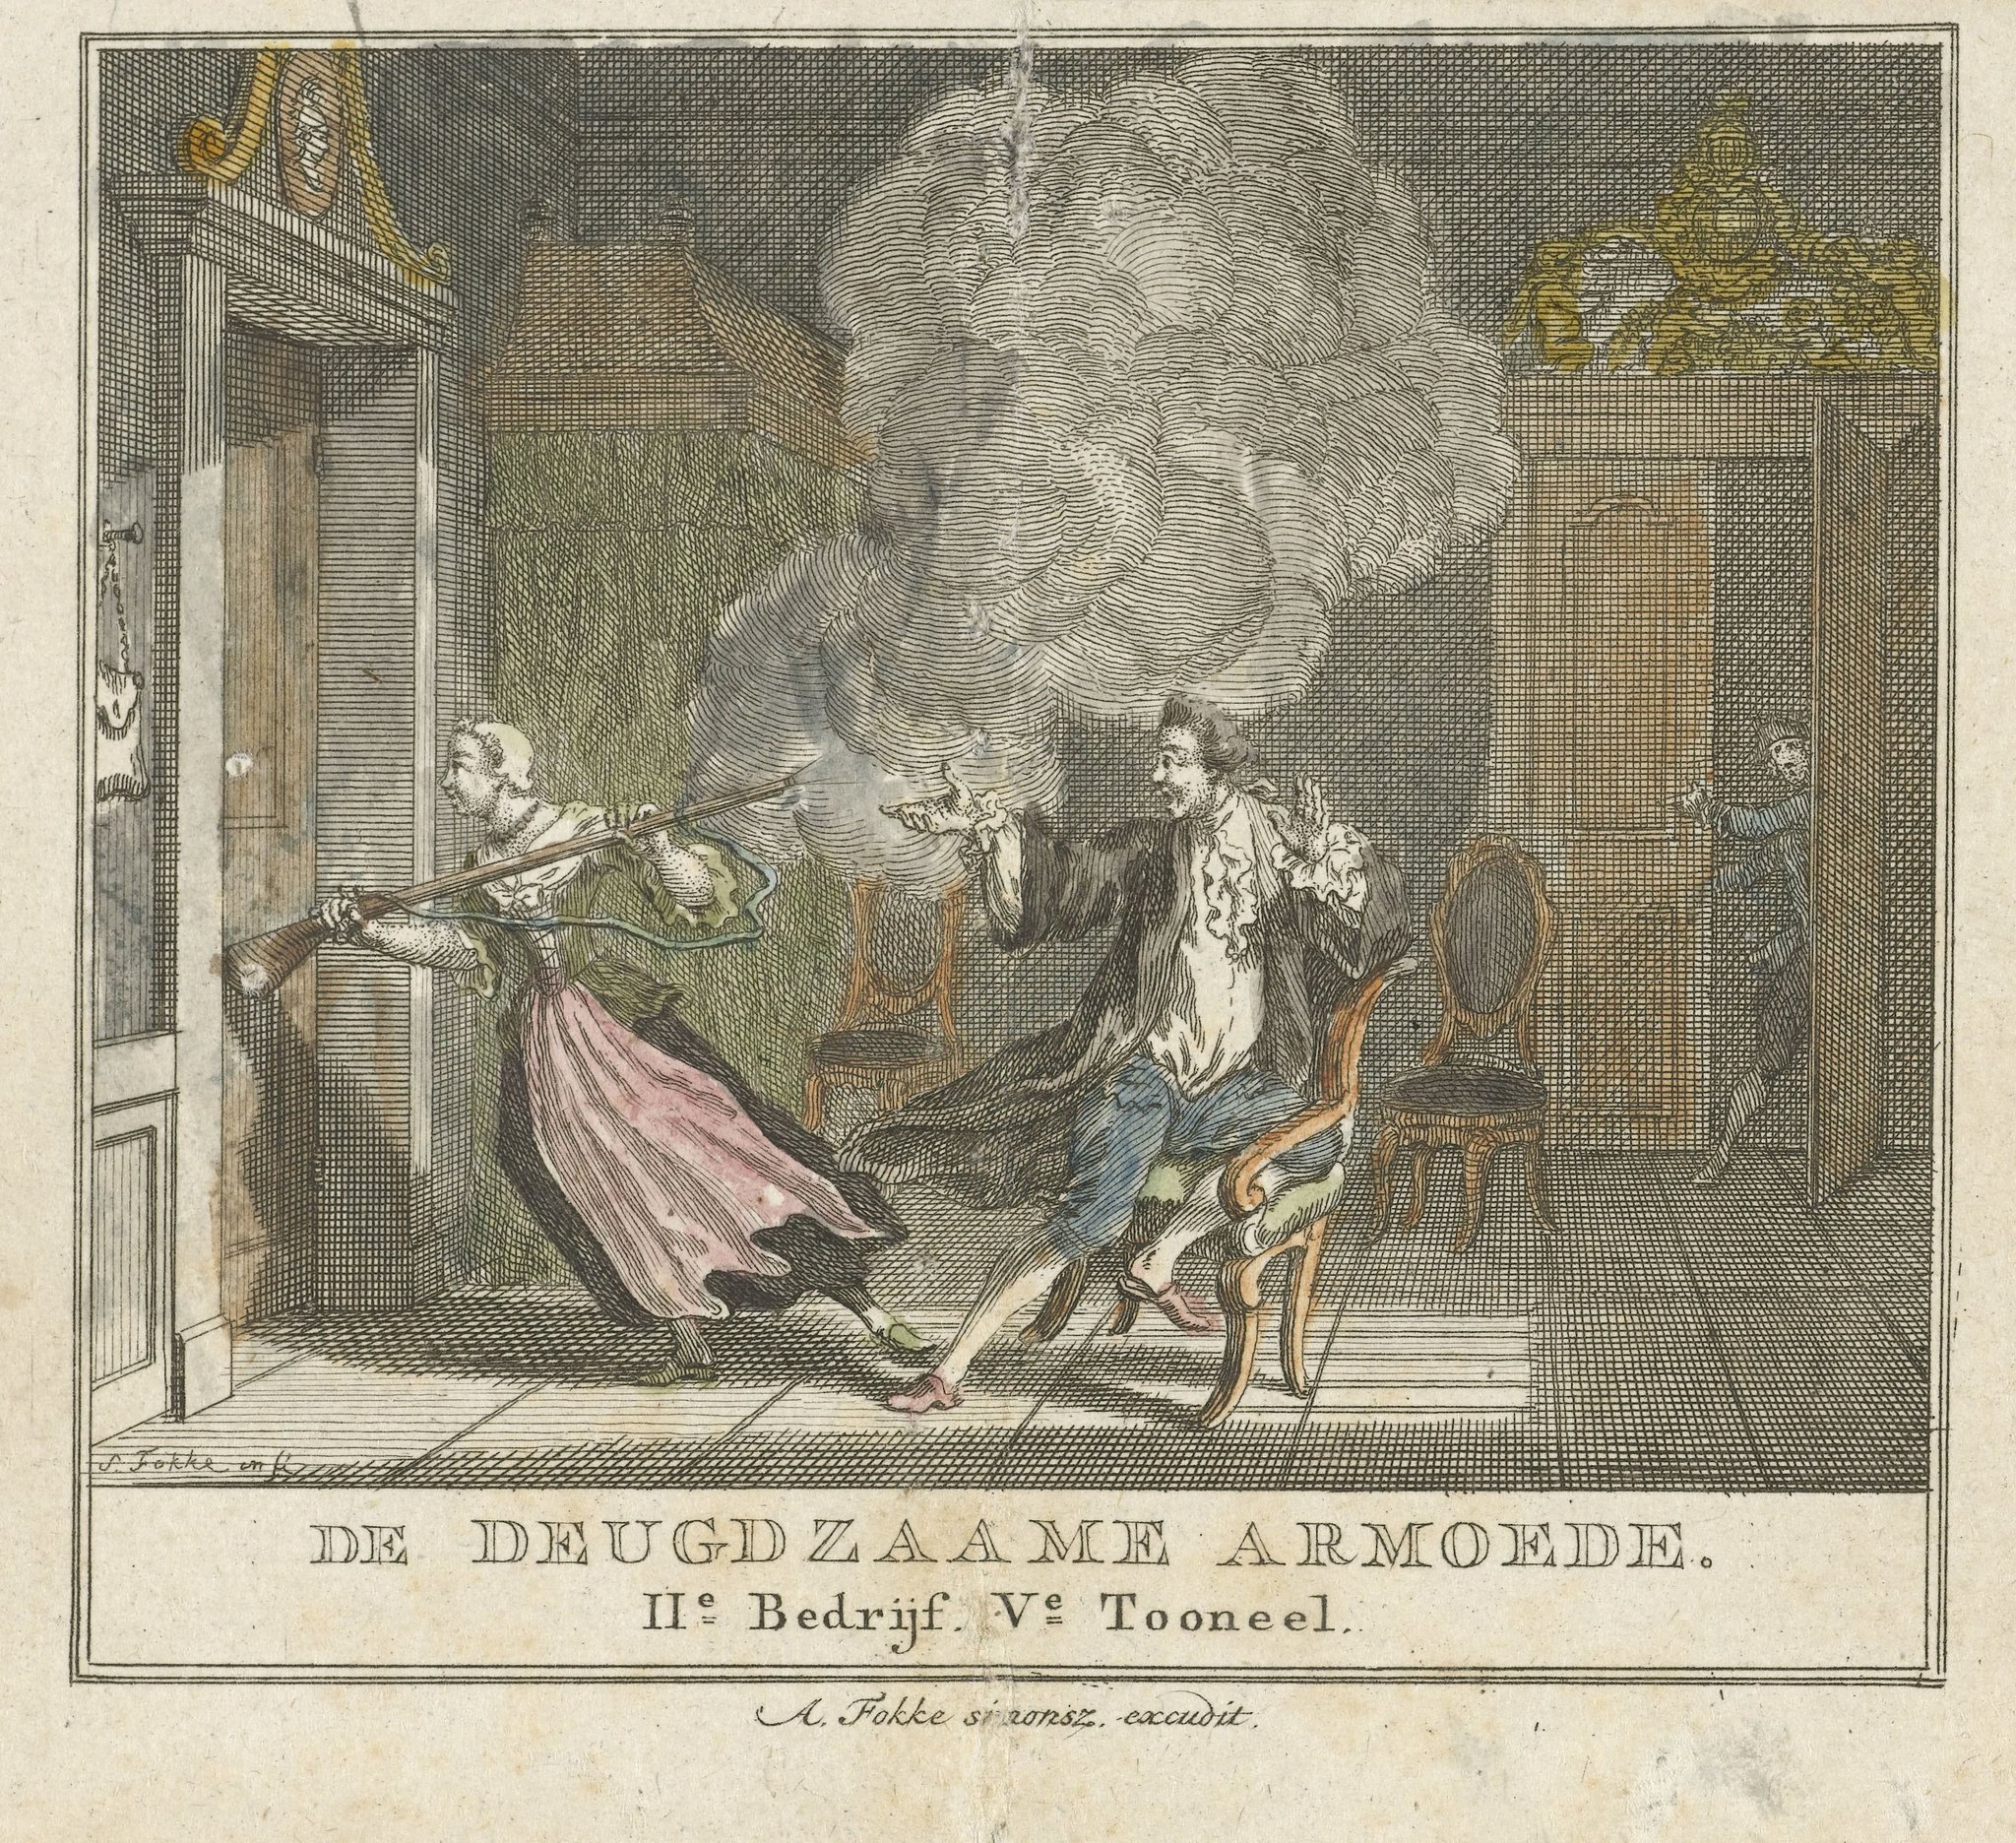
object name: print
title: De Deugdzaame Armoede. IIe Bedrijf. Ve Tooneel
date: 1774-1793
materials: paper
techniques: etching, hand coloring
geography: amsterdam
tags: firearms: rifle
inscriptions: collector's mark: Lugt 2228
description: In een vertrek probeert een vrouw de deur met de kolf van een geweer open te krijgen. Op een stoel achter haar zit een man die verschrikt wijst op de loop van het geweer waaruit rook komt. Deze prent is vervaardigd voor het blijspel "De deugdzaame armoede" van Louis-Sébastien Mercier.